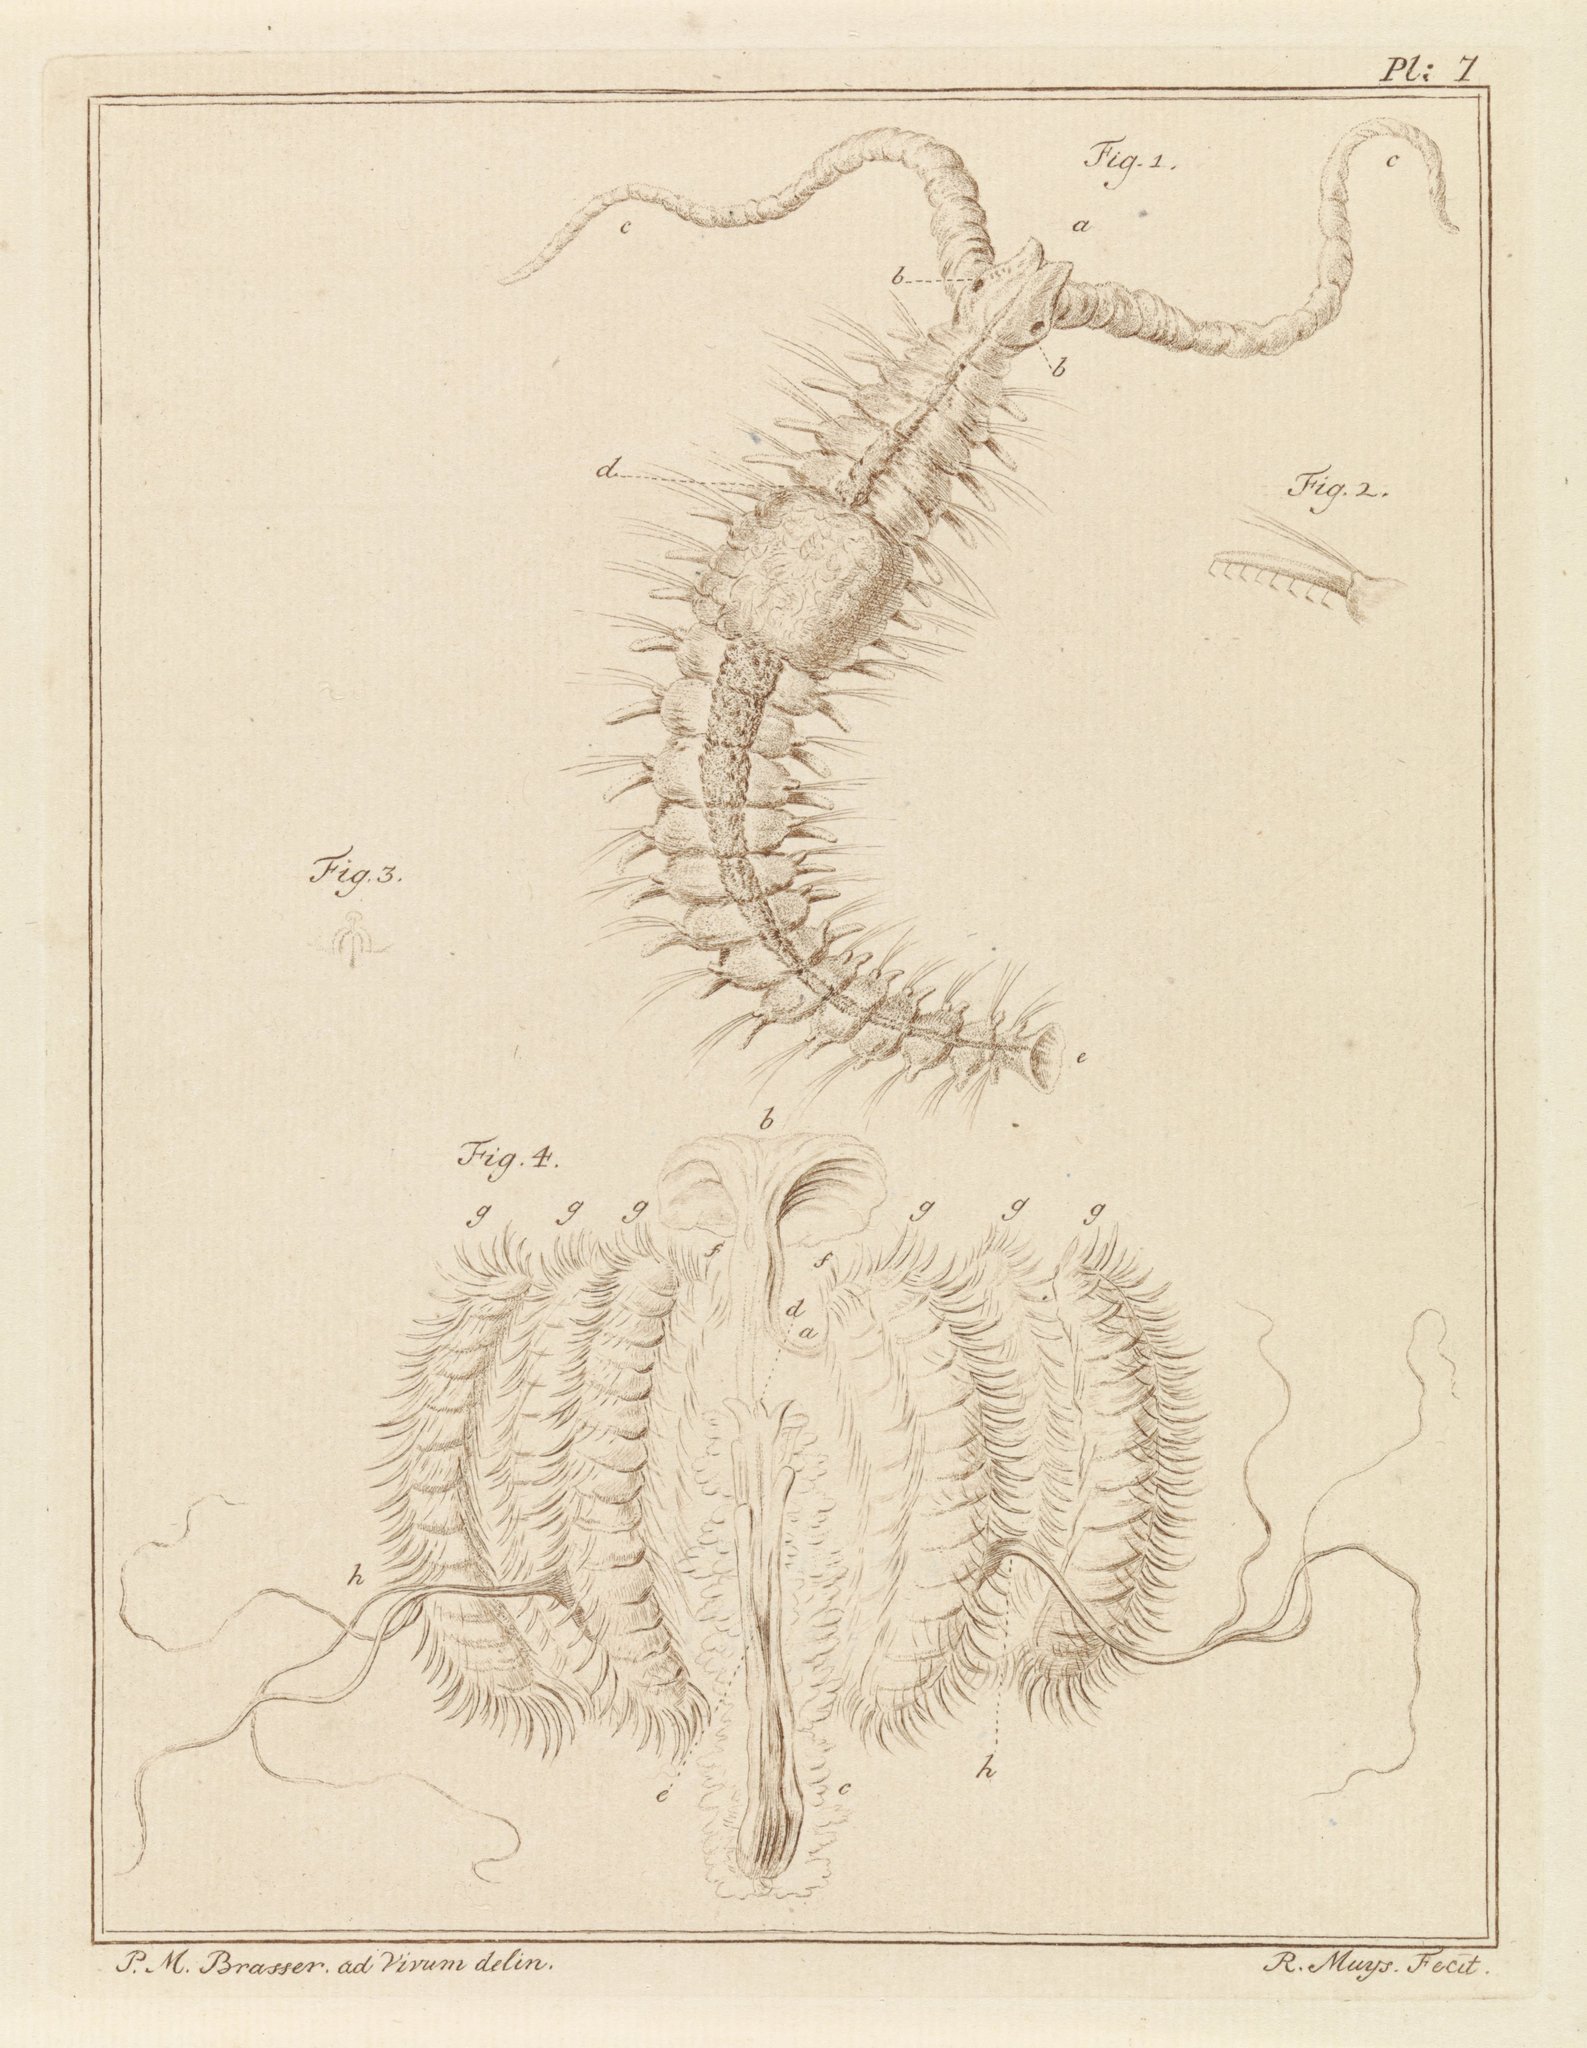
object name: book illustration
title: Franjeworm en een ribkwalletje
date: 1778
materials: paper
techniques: etching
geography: rotterdam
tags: coelenterata (+ animals ~ biological investigation), coelenterata: jelly-fish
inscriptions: collector's mark: Lugt 2228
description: Figuur 1 en 2 tonen de Franjeworm, ook wel slikkokerworm genoemd, op ware grootte en uitvergroot. Figuur 3 en 4 tonen een ribkwalletje, ook wel de zeshoekige Beroë genoemd, op ware grootte en uitvergroot. Beiden zijn zeedieren. Rechtsboven: Pl. 7. Prent uit een boek over binnen- en buitenlandse land- en waterdieren.